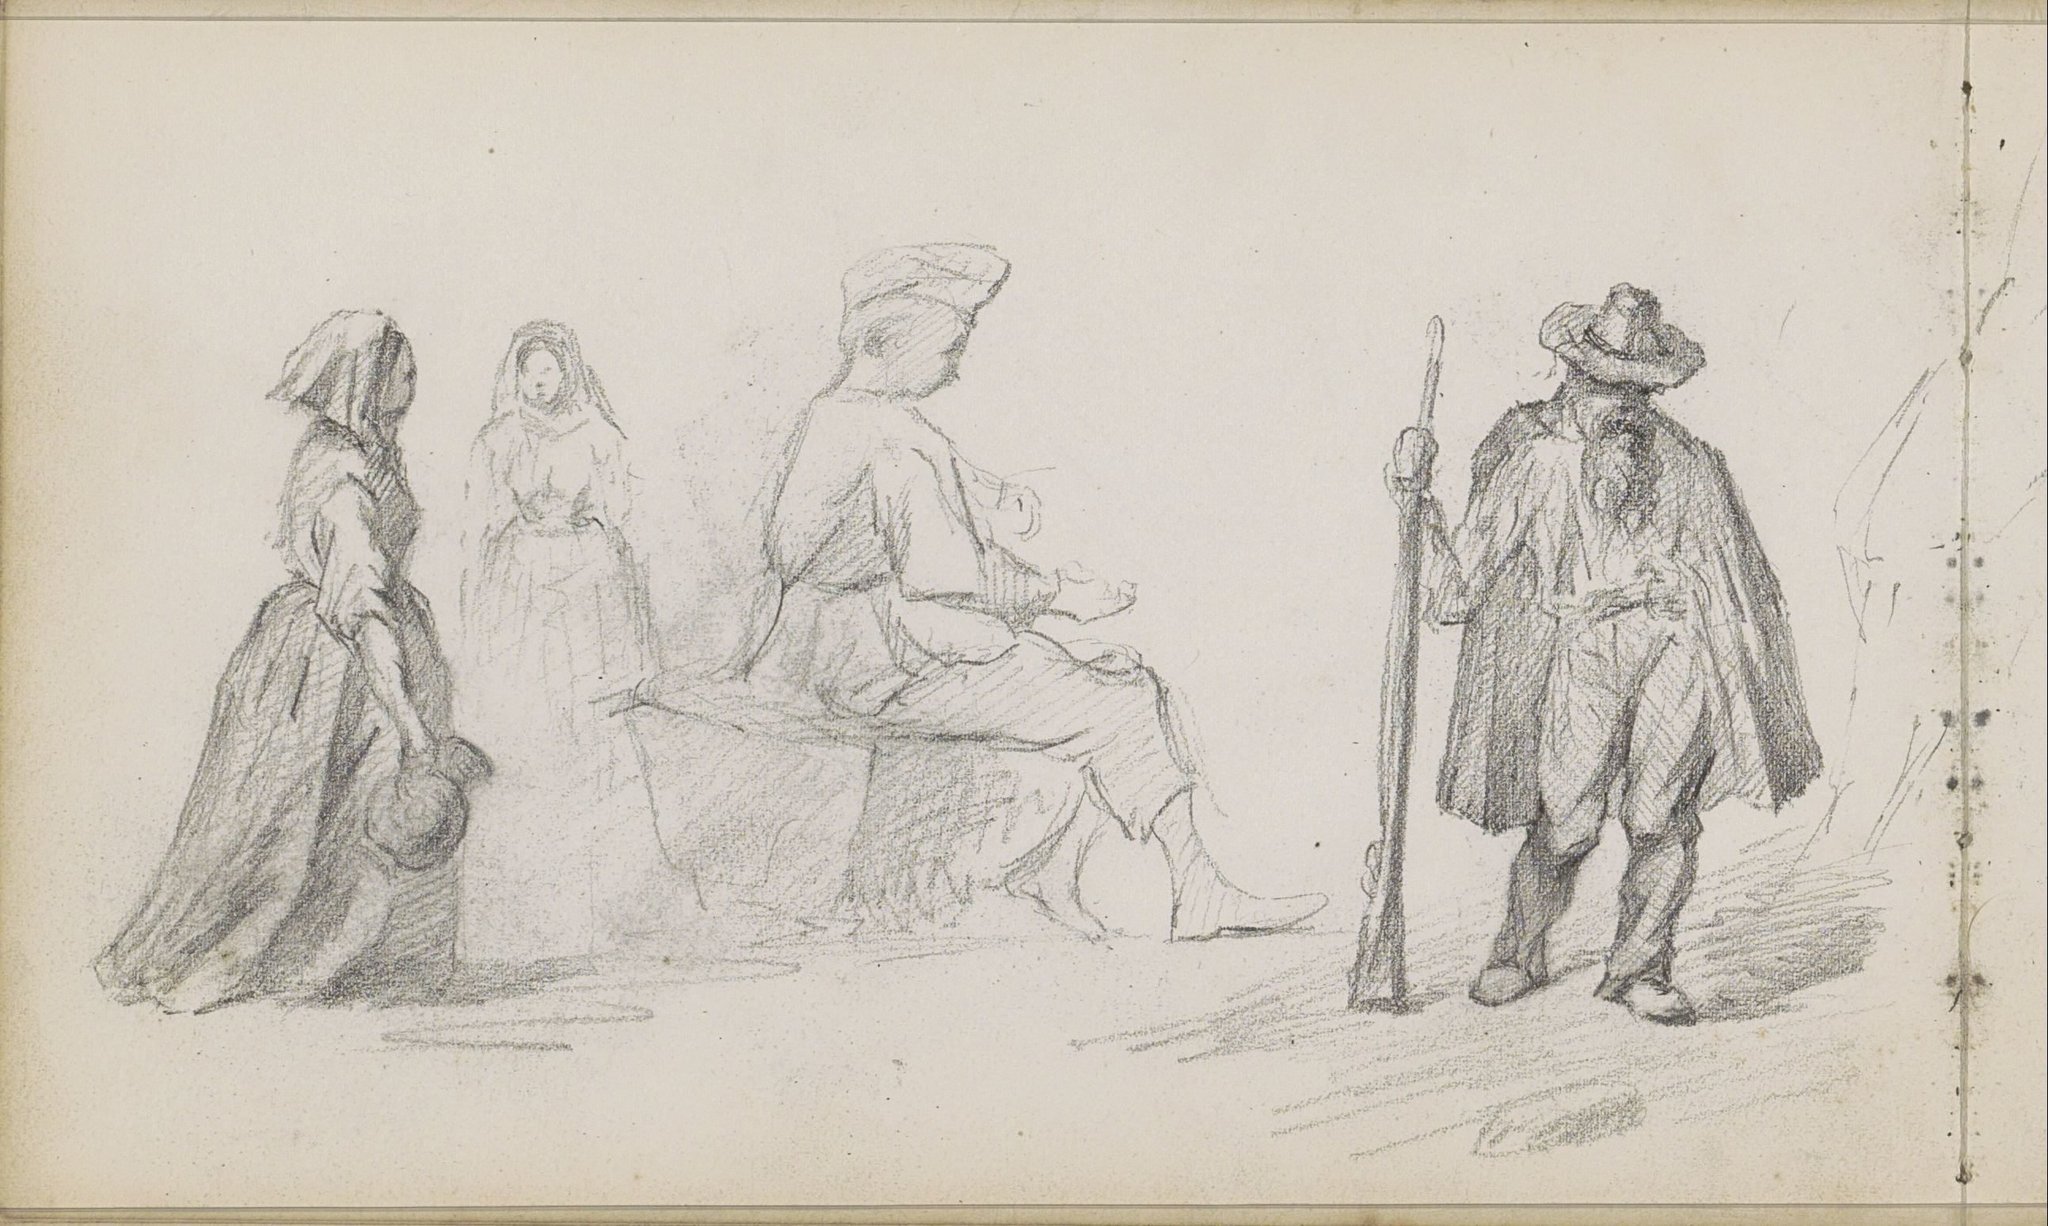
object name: sketchbook leaf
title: Vrouw met een kruik en een man met een geweer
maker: willem cornelis rip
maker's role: draughtsman, painter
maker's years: 1856-1922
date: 1874-1875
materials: paper, pencil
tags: firearms: rifle, standing figure - aa - female human figure, container of ceramics: jar, jug, pot, vase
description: Tevens studies van een staande vrouw en zittende man. Blad 30 verso uit een schetsboek met 46 bladen.